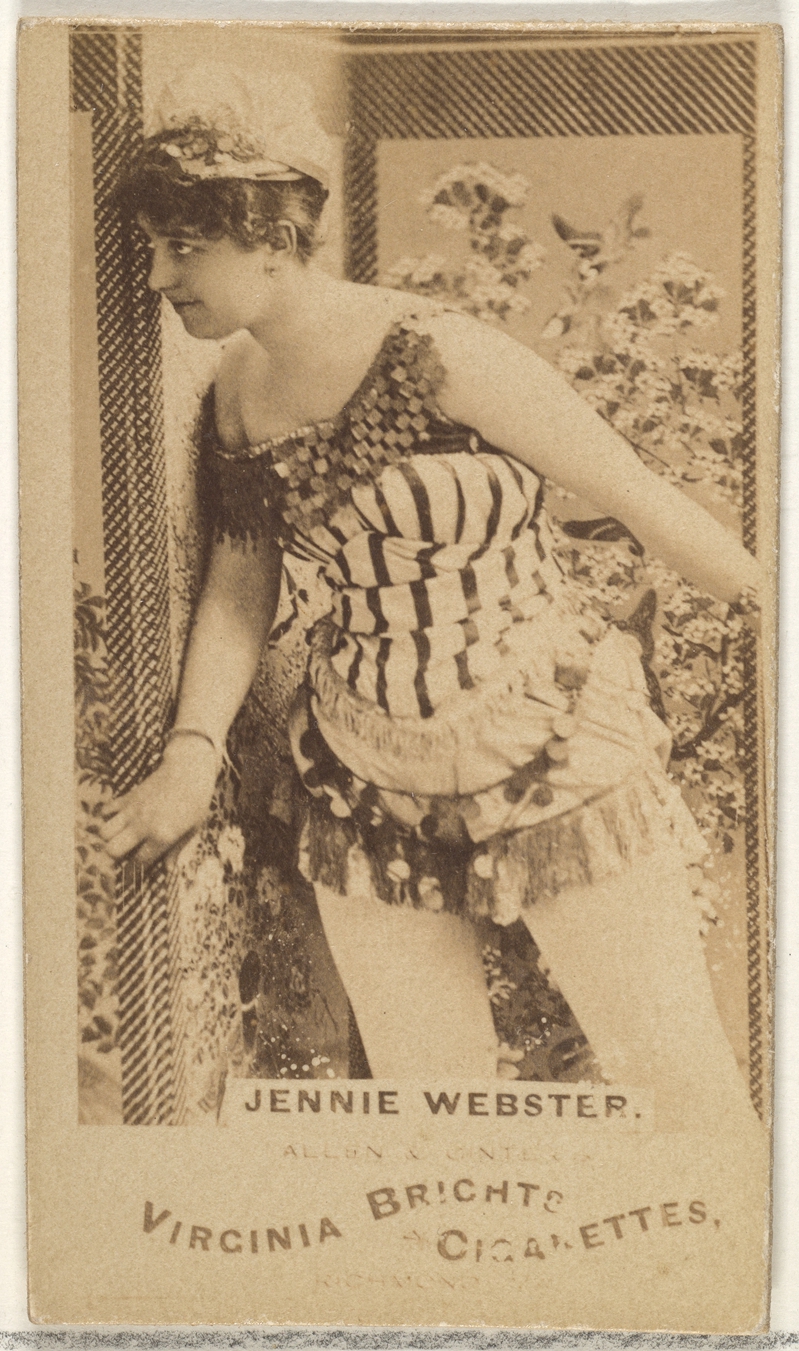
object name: photograph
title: Jennie Webster, from the Actors and Actresses series (N45, Type 1) for Virginia Brights Cigarettes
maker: allen & ginter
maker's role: publisher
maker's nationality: american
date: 1888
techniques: albumen silver print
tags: portraits,women,actresses